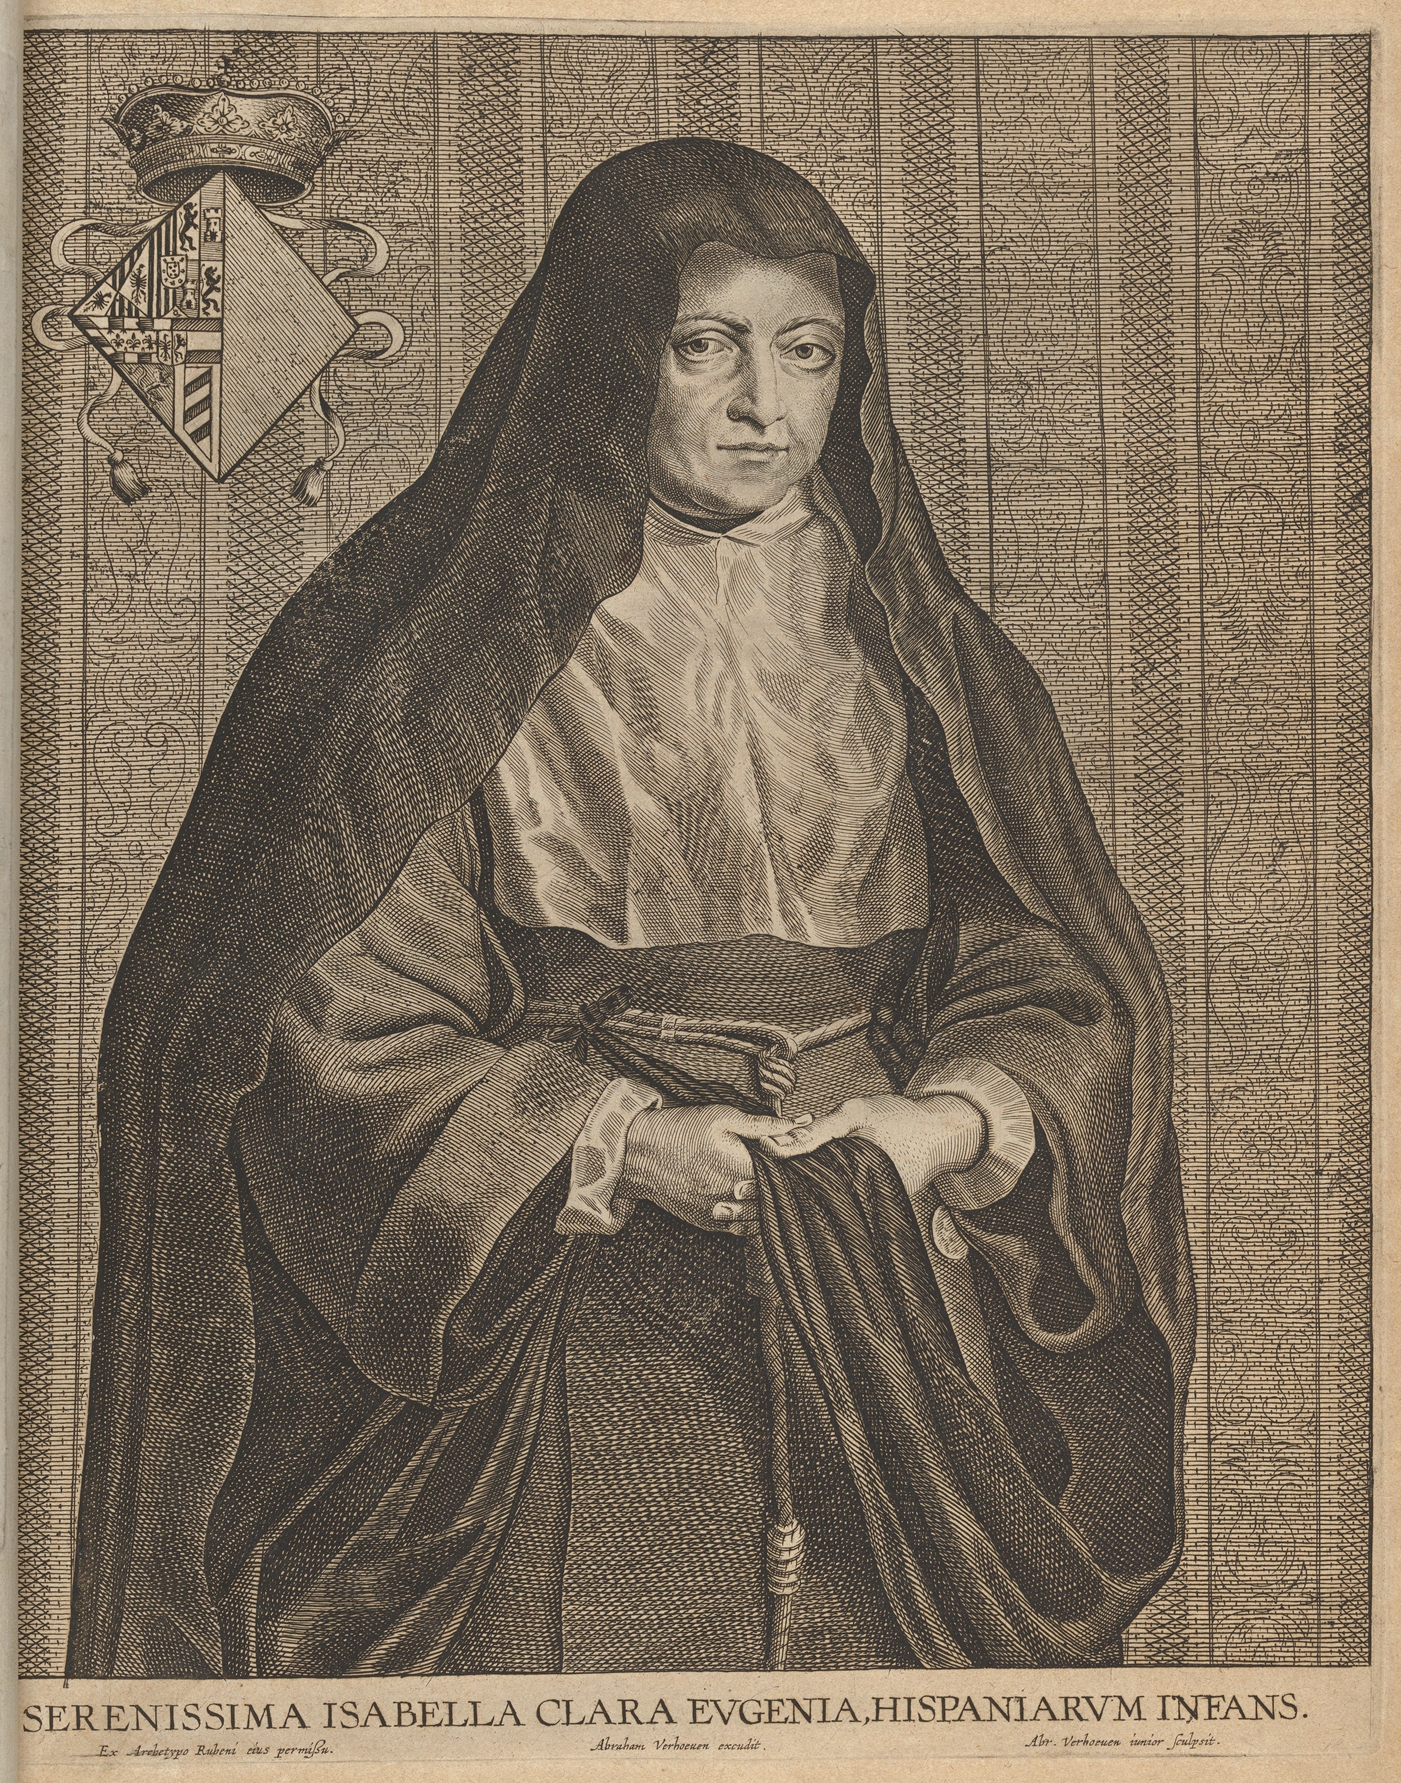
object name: print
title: Isabella Clara Eugenia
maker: abraham verhouven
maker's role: artist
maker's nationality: flemish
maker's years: 1580-1639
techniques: engraving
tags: portraits,women,coat of arms